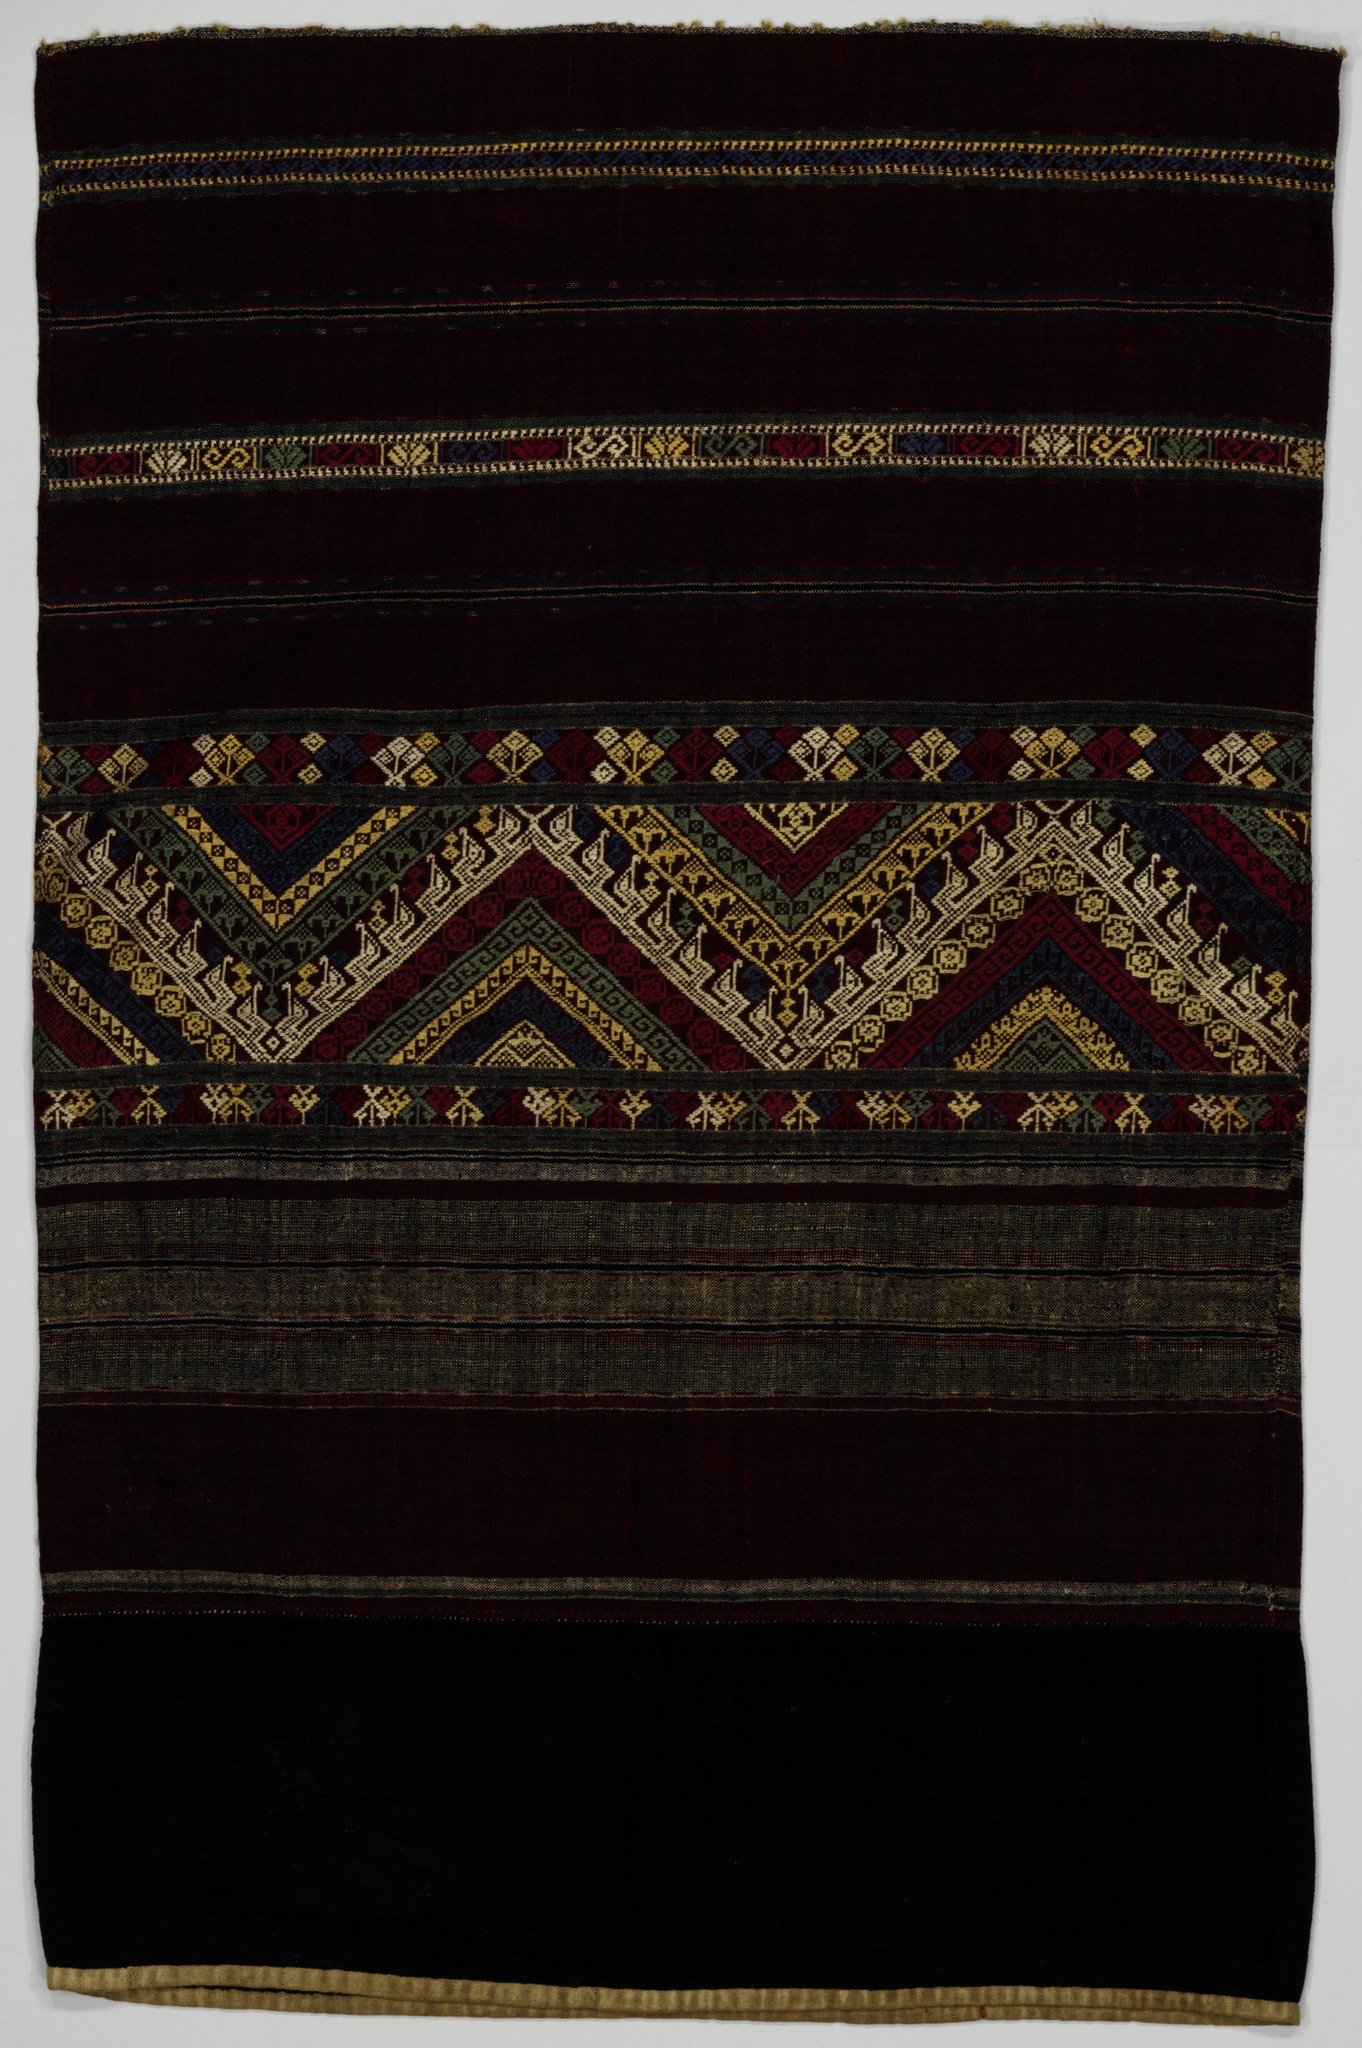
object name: cloth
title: Pa sin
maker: Anonymous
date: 1900-1949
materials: cotton, silk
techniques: weave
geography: laos